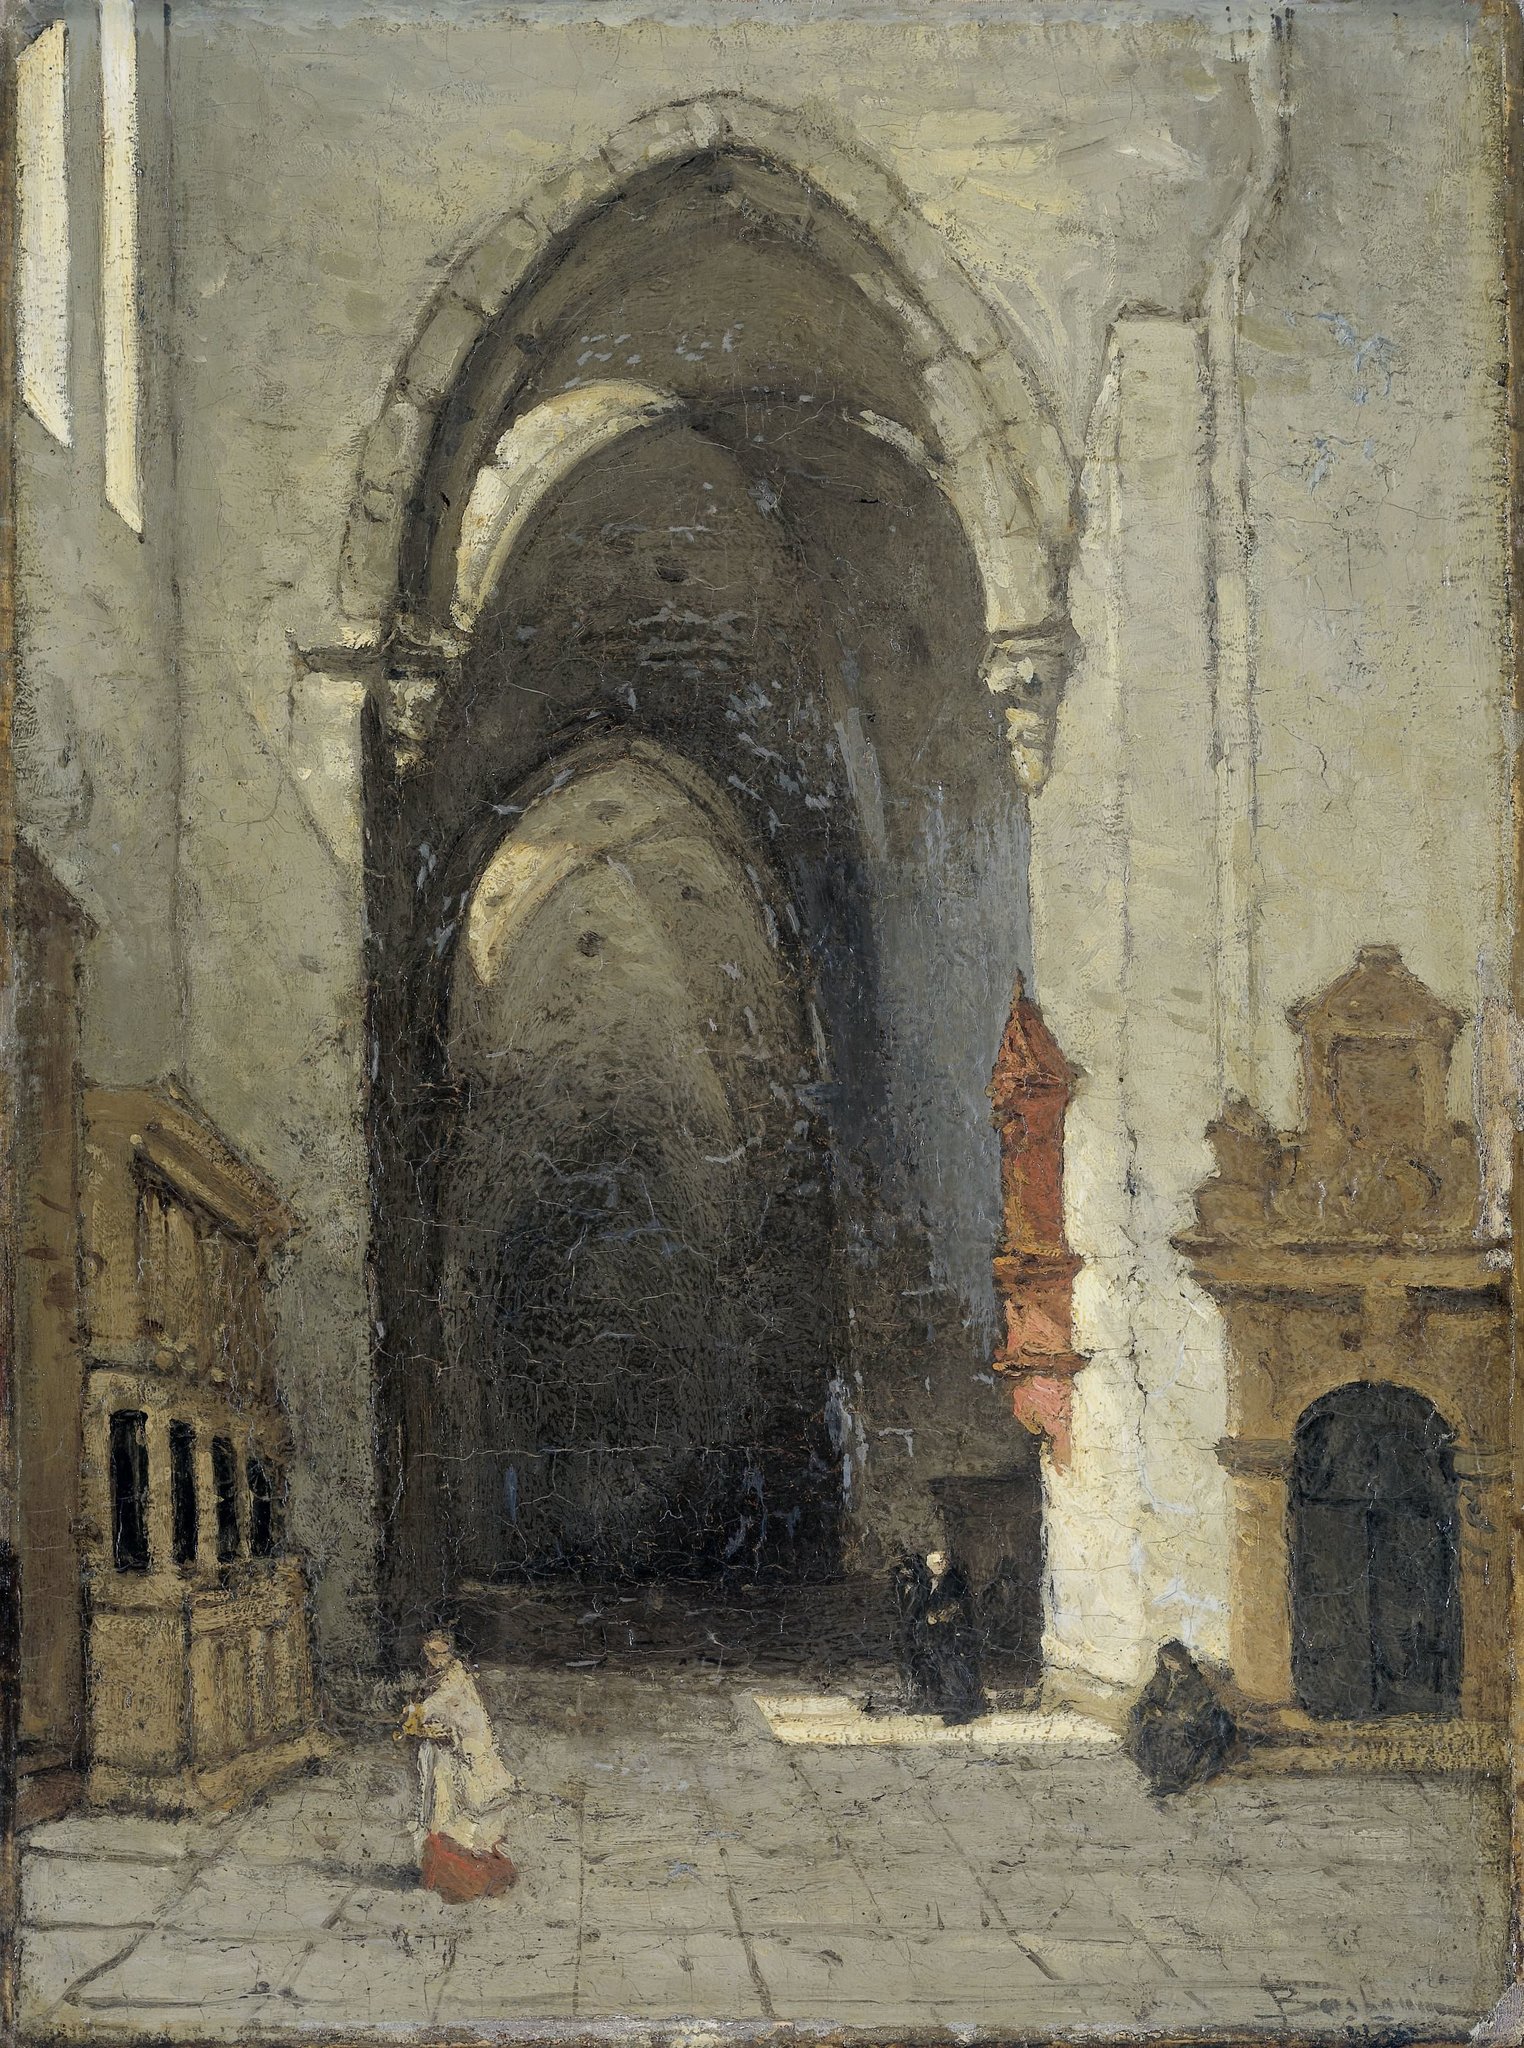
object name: painting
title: Interior of the Dom in Trier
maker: johannes bosboom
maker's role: draughtsman, painter, print maker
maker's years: 1817-1891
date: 1870-1880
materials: oil, panel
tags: interior of church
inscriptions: signature: ‘Bosboom’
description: Interieur van de Domkerk te Trier. Gezicht in een zijbeuk met enige figuurtjes.